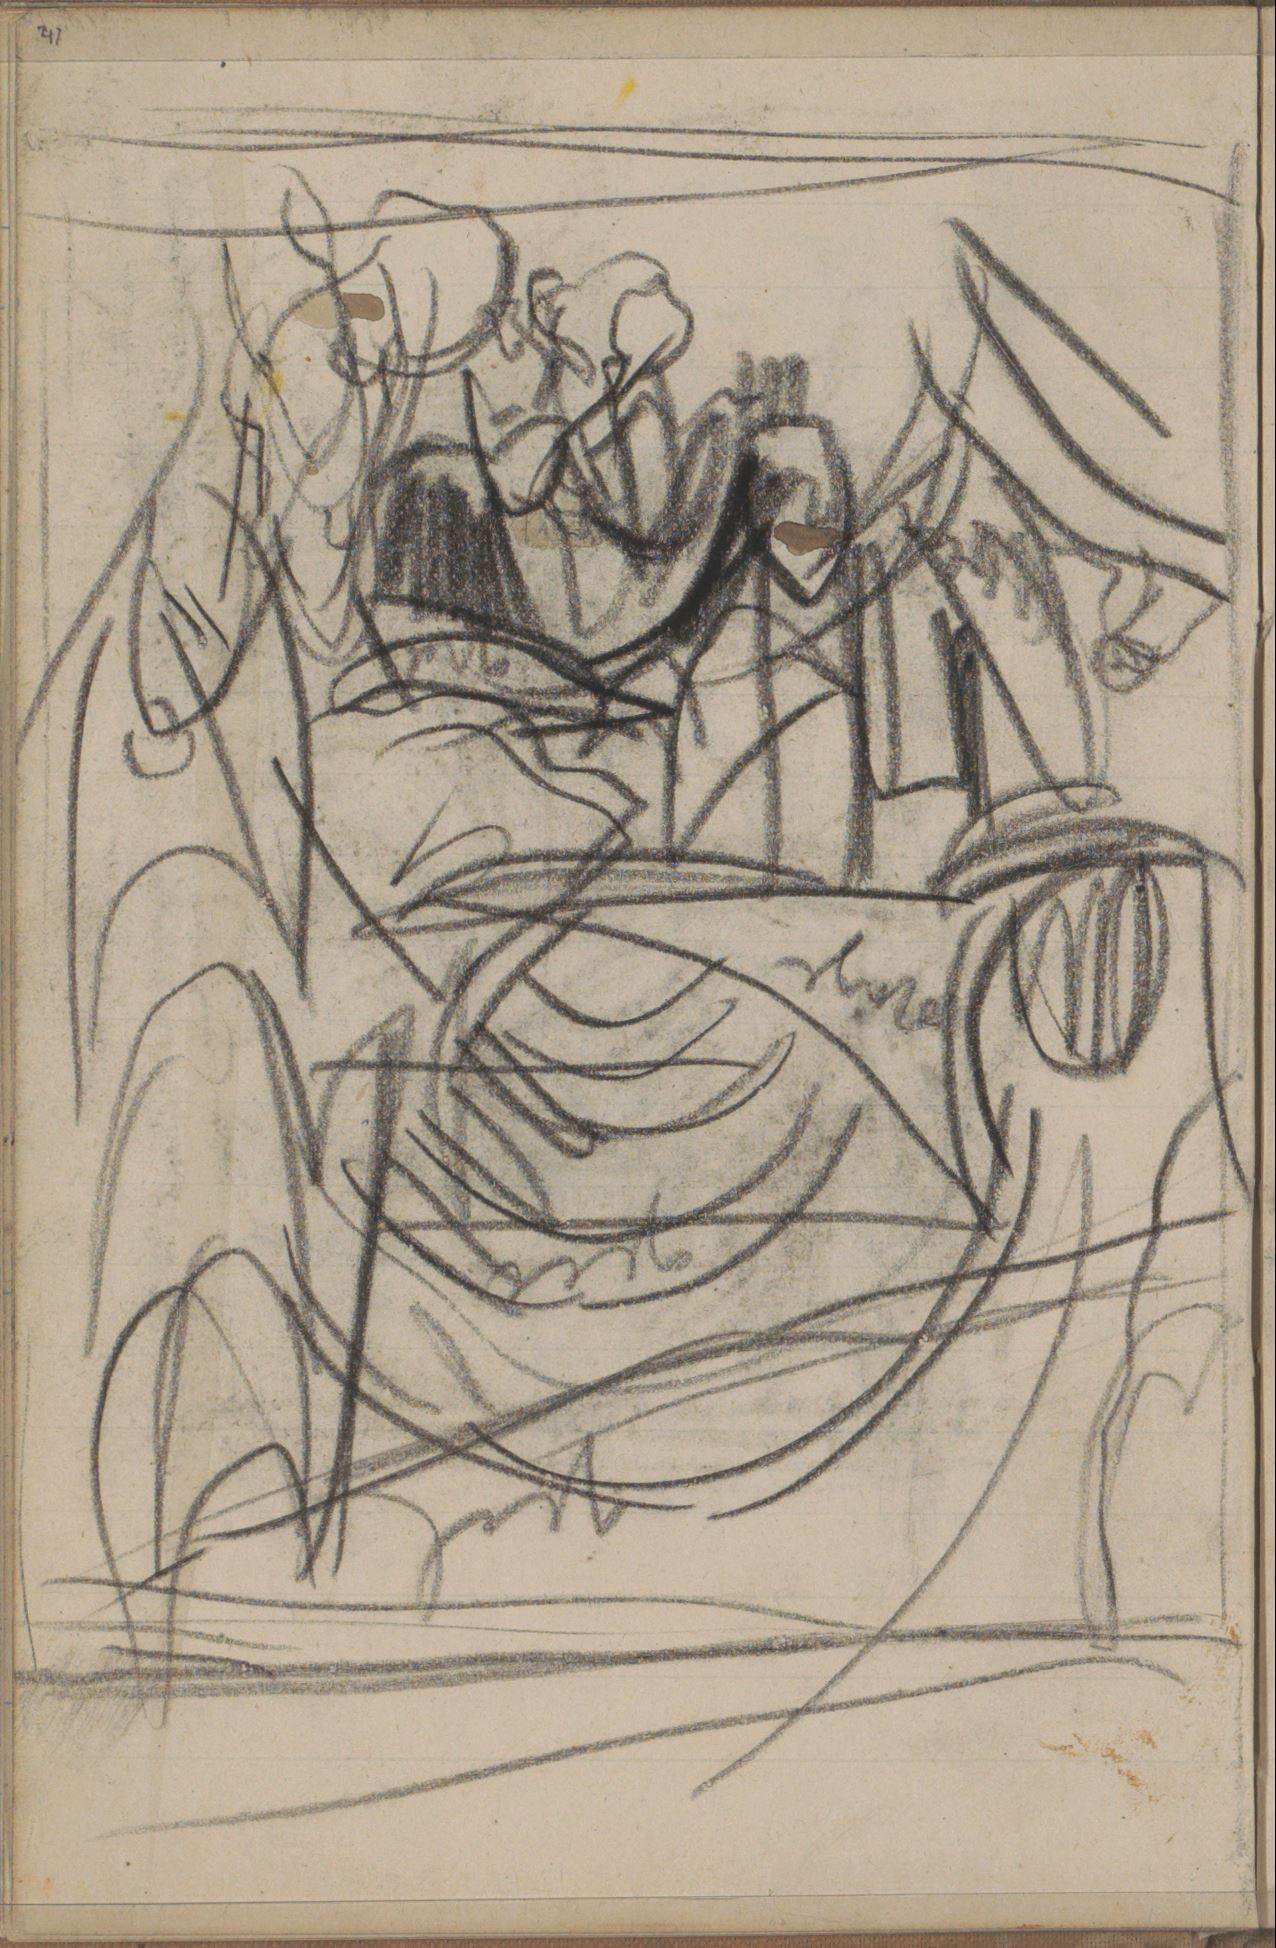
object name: sketchbook leaf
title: Figuren onder een koepeldak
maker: marius bauer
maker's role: draughtsman, print maker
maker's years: 1867-1932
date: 1888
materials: chalk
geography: istanbul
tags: dome ~ architecture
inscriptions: kleurnotitie, handgeschreven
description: Pagina 47 uit een schetsboek met 56 bladen.